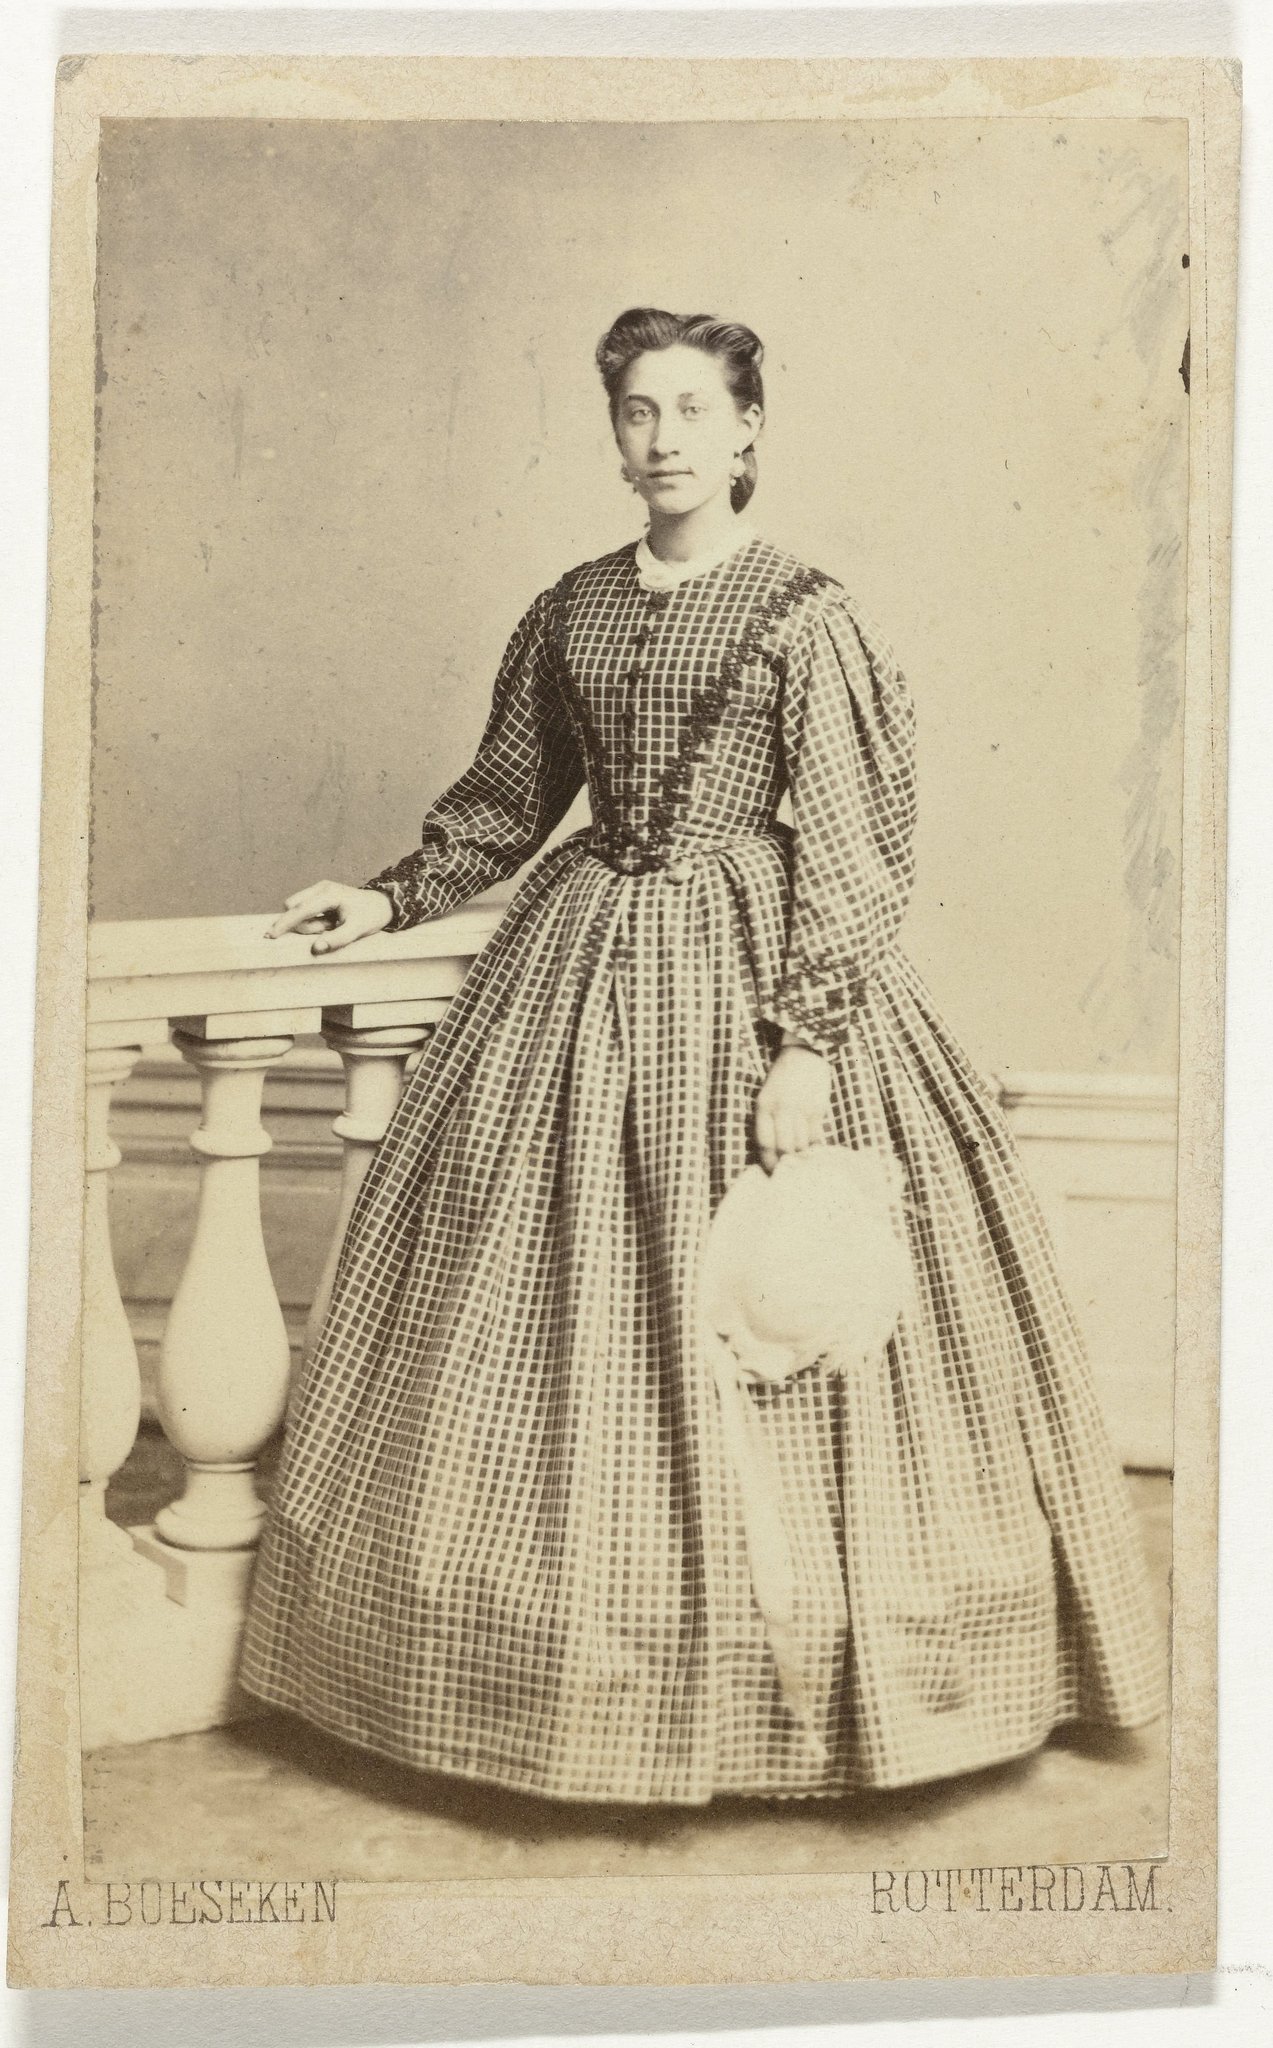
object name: carte de visite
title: Portret van Jacoba Teves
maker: a. böeseken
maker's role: fotograaf, lithograaf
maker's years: 1834-1919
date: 1869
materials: cardboard, paper, photographic support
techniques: albumen print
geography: rotterdam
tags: jacoba teves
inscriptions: annotation: ‘Ter herinnering aan/Jacoba Teves/geboren 21 November 1849/Overleden 3 September 1868’, address: ‘A. Böeseken/Photographisch Atelier/Rotterdam/Hoogstraat over de/Vlasmarkt’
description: Vrouw in een geruite japon, met een witte hoed in haar hand, staand naast een balustrade.